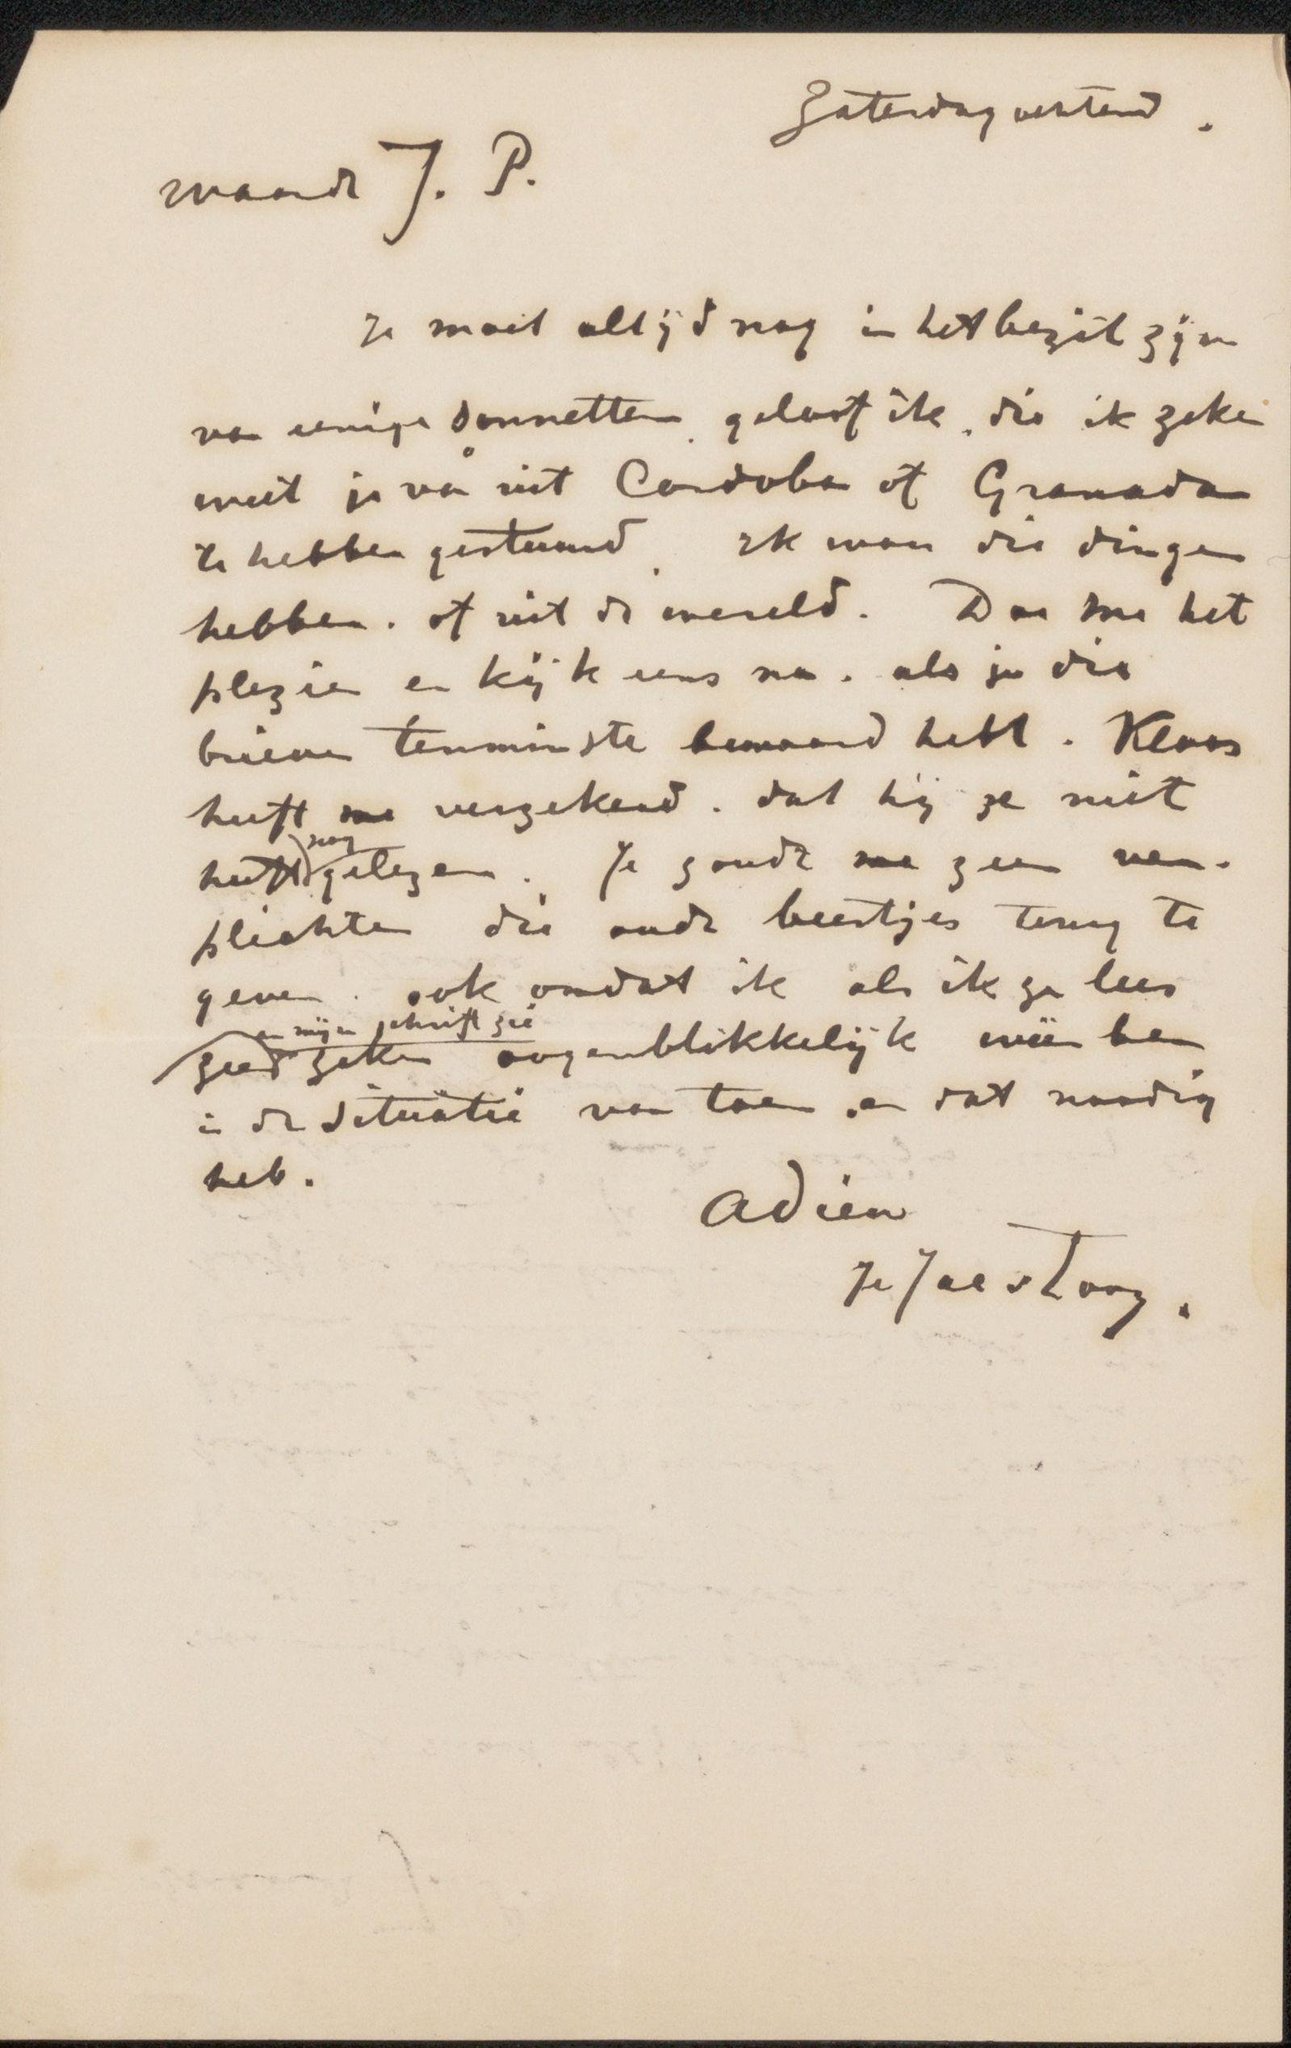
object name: letter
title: Brief aan Jan Veth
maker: jac van looij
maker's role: draughtsman, painter, print maker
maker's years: 1855-1930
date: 1865-1925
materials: ink, paper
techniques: pen, writing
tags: painter, print maker, draughtsman, designer, jan veth, literature ~ arts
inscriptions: collector's mark: ‘RPK’